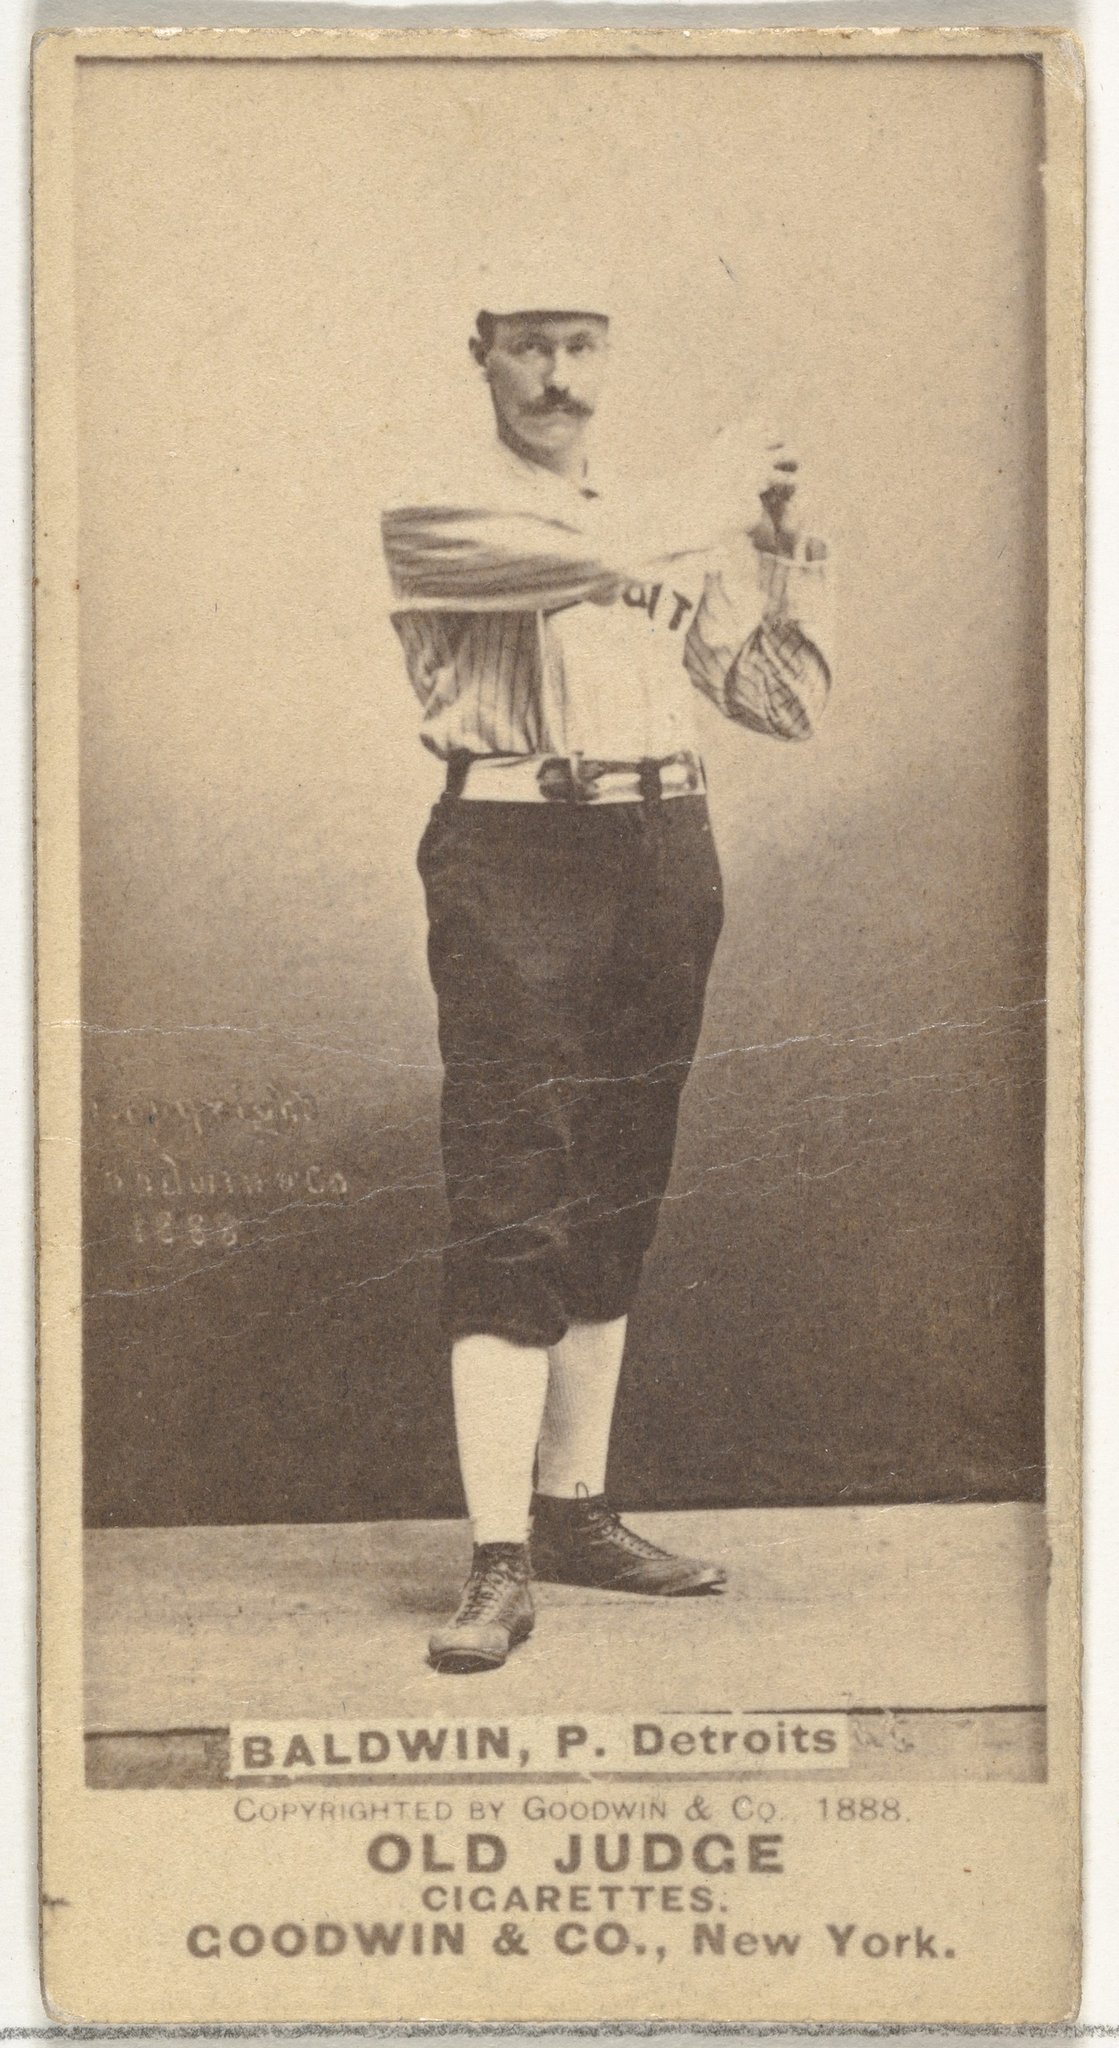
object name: baseball card, photograph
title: Charles B. "Lady" Baldwin, Pitcher, Detroit Wolverines, from the Old Judge series (N172) for Old Judge Cigarettes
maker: goodwin & company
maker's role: publisher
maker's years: 1850-1950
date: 1888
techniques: albumen silver print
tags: men,portraits,baseball,athletes